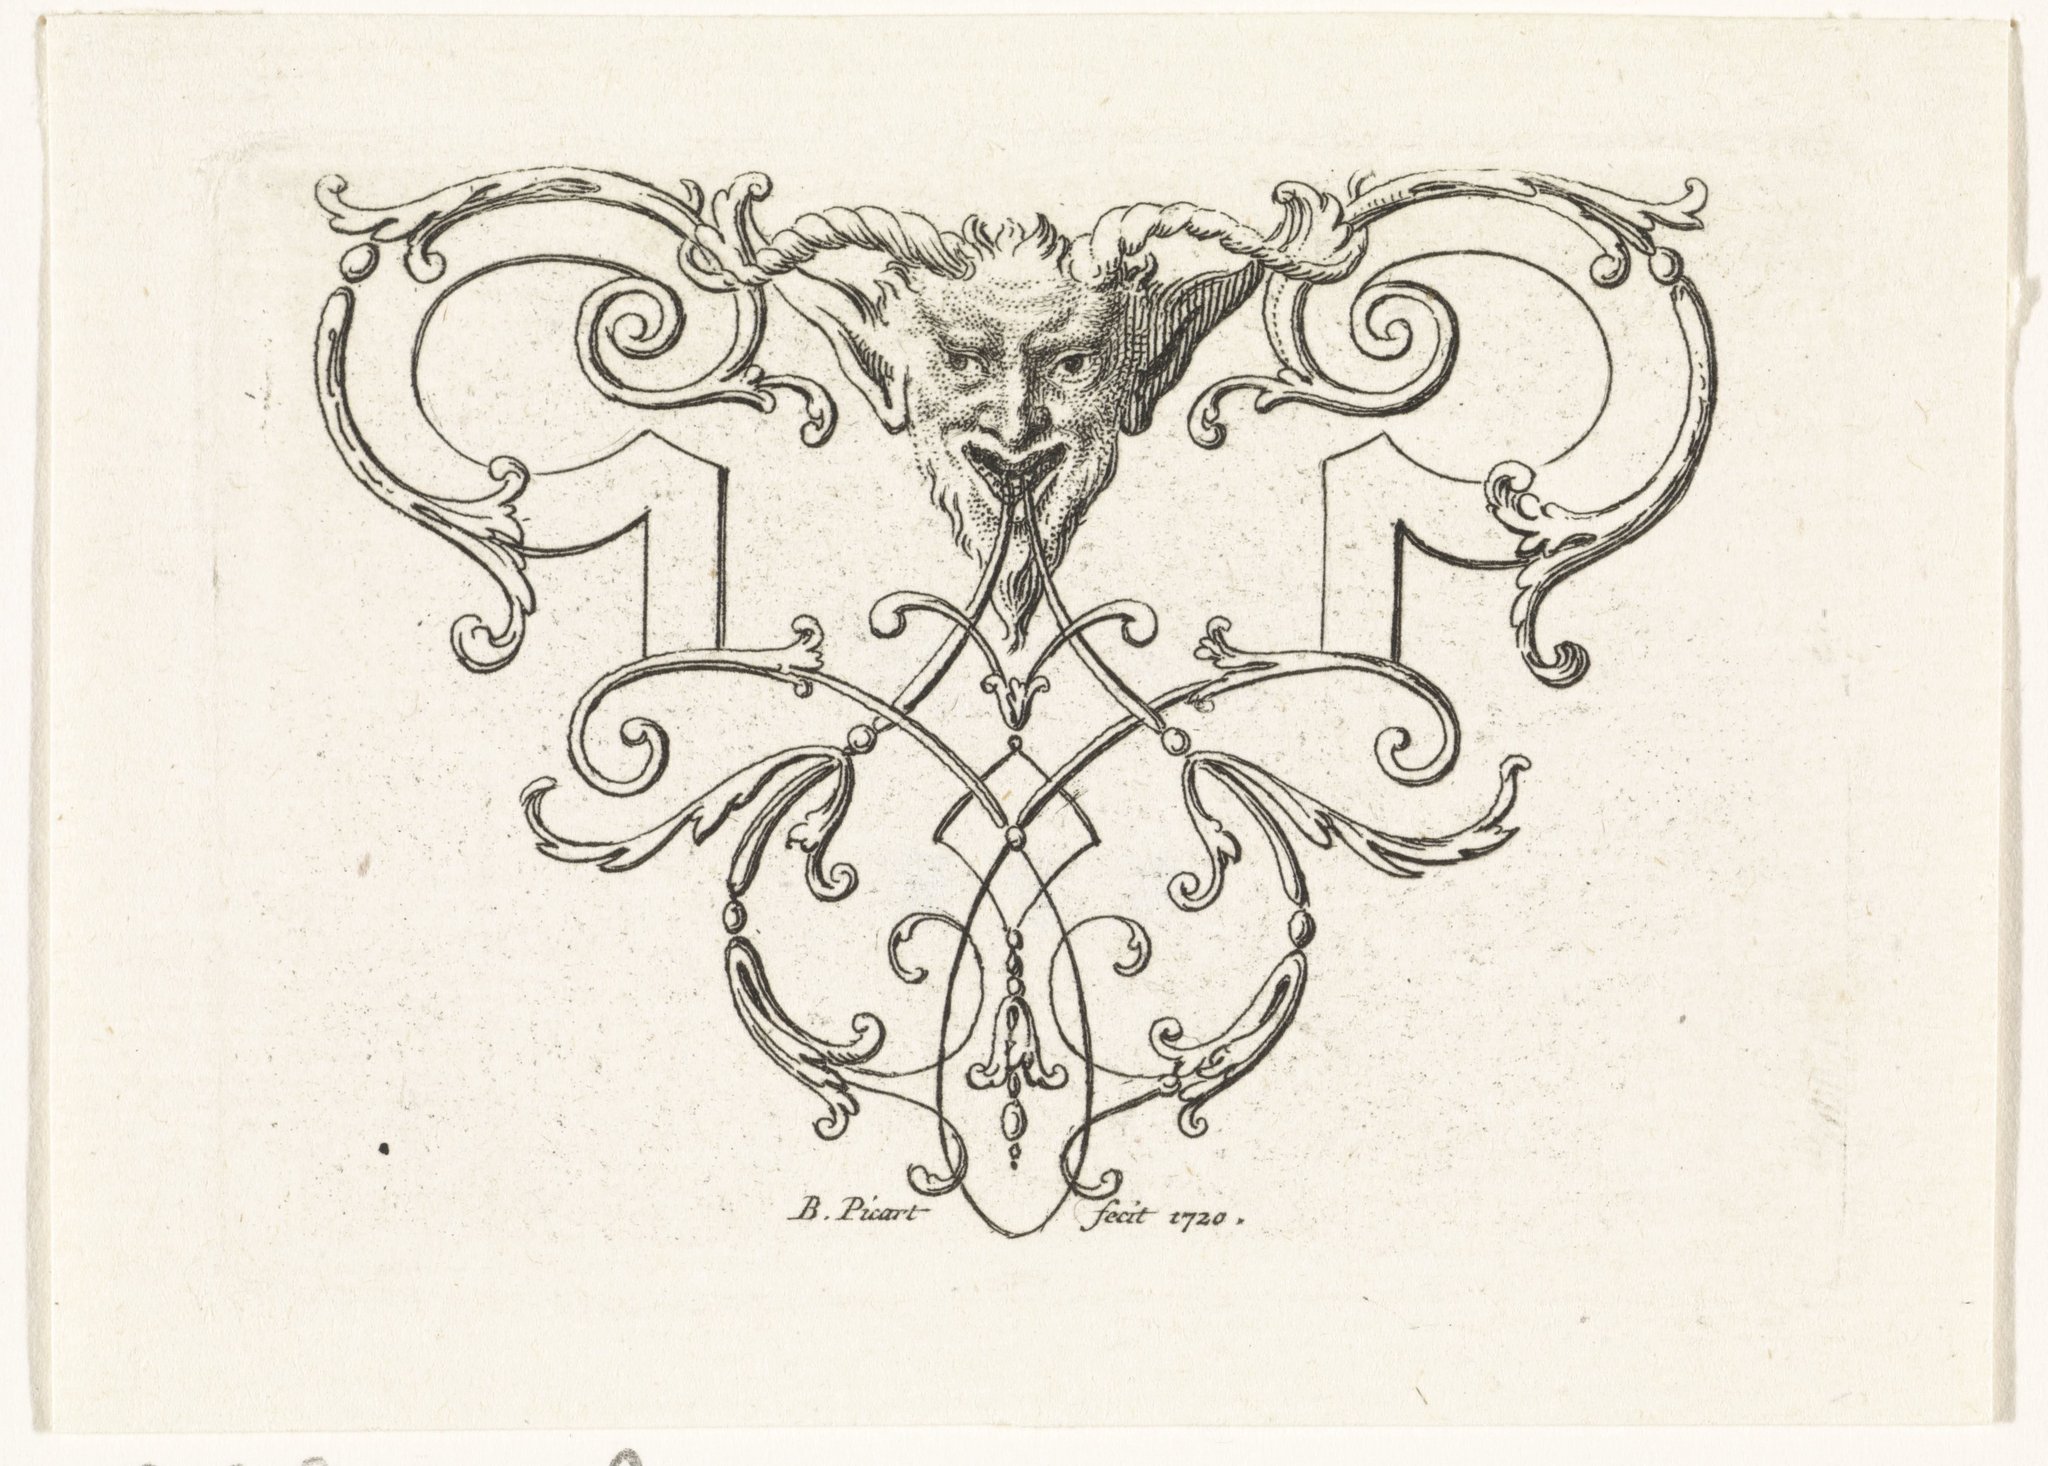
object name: print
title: Ornament met sater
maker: bernard picart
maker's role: draughtsman, print maker, publisher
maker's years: 1673-1733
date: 1720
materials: paper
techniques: engraving, etching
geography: amsterdam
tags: mask, mascaron ~ ornament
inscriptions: collector's mark: Lugt 2233